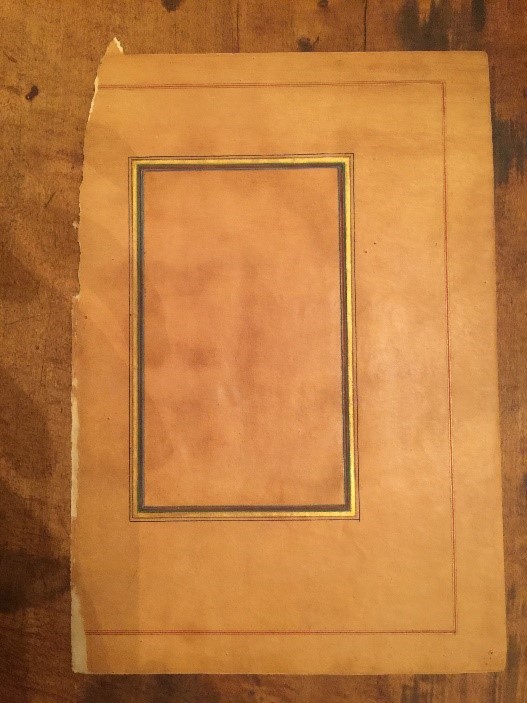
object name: folio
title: Decorated Folio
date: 1501-1900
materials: gold, ink, paper, watercolor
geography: iran